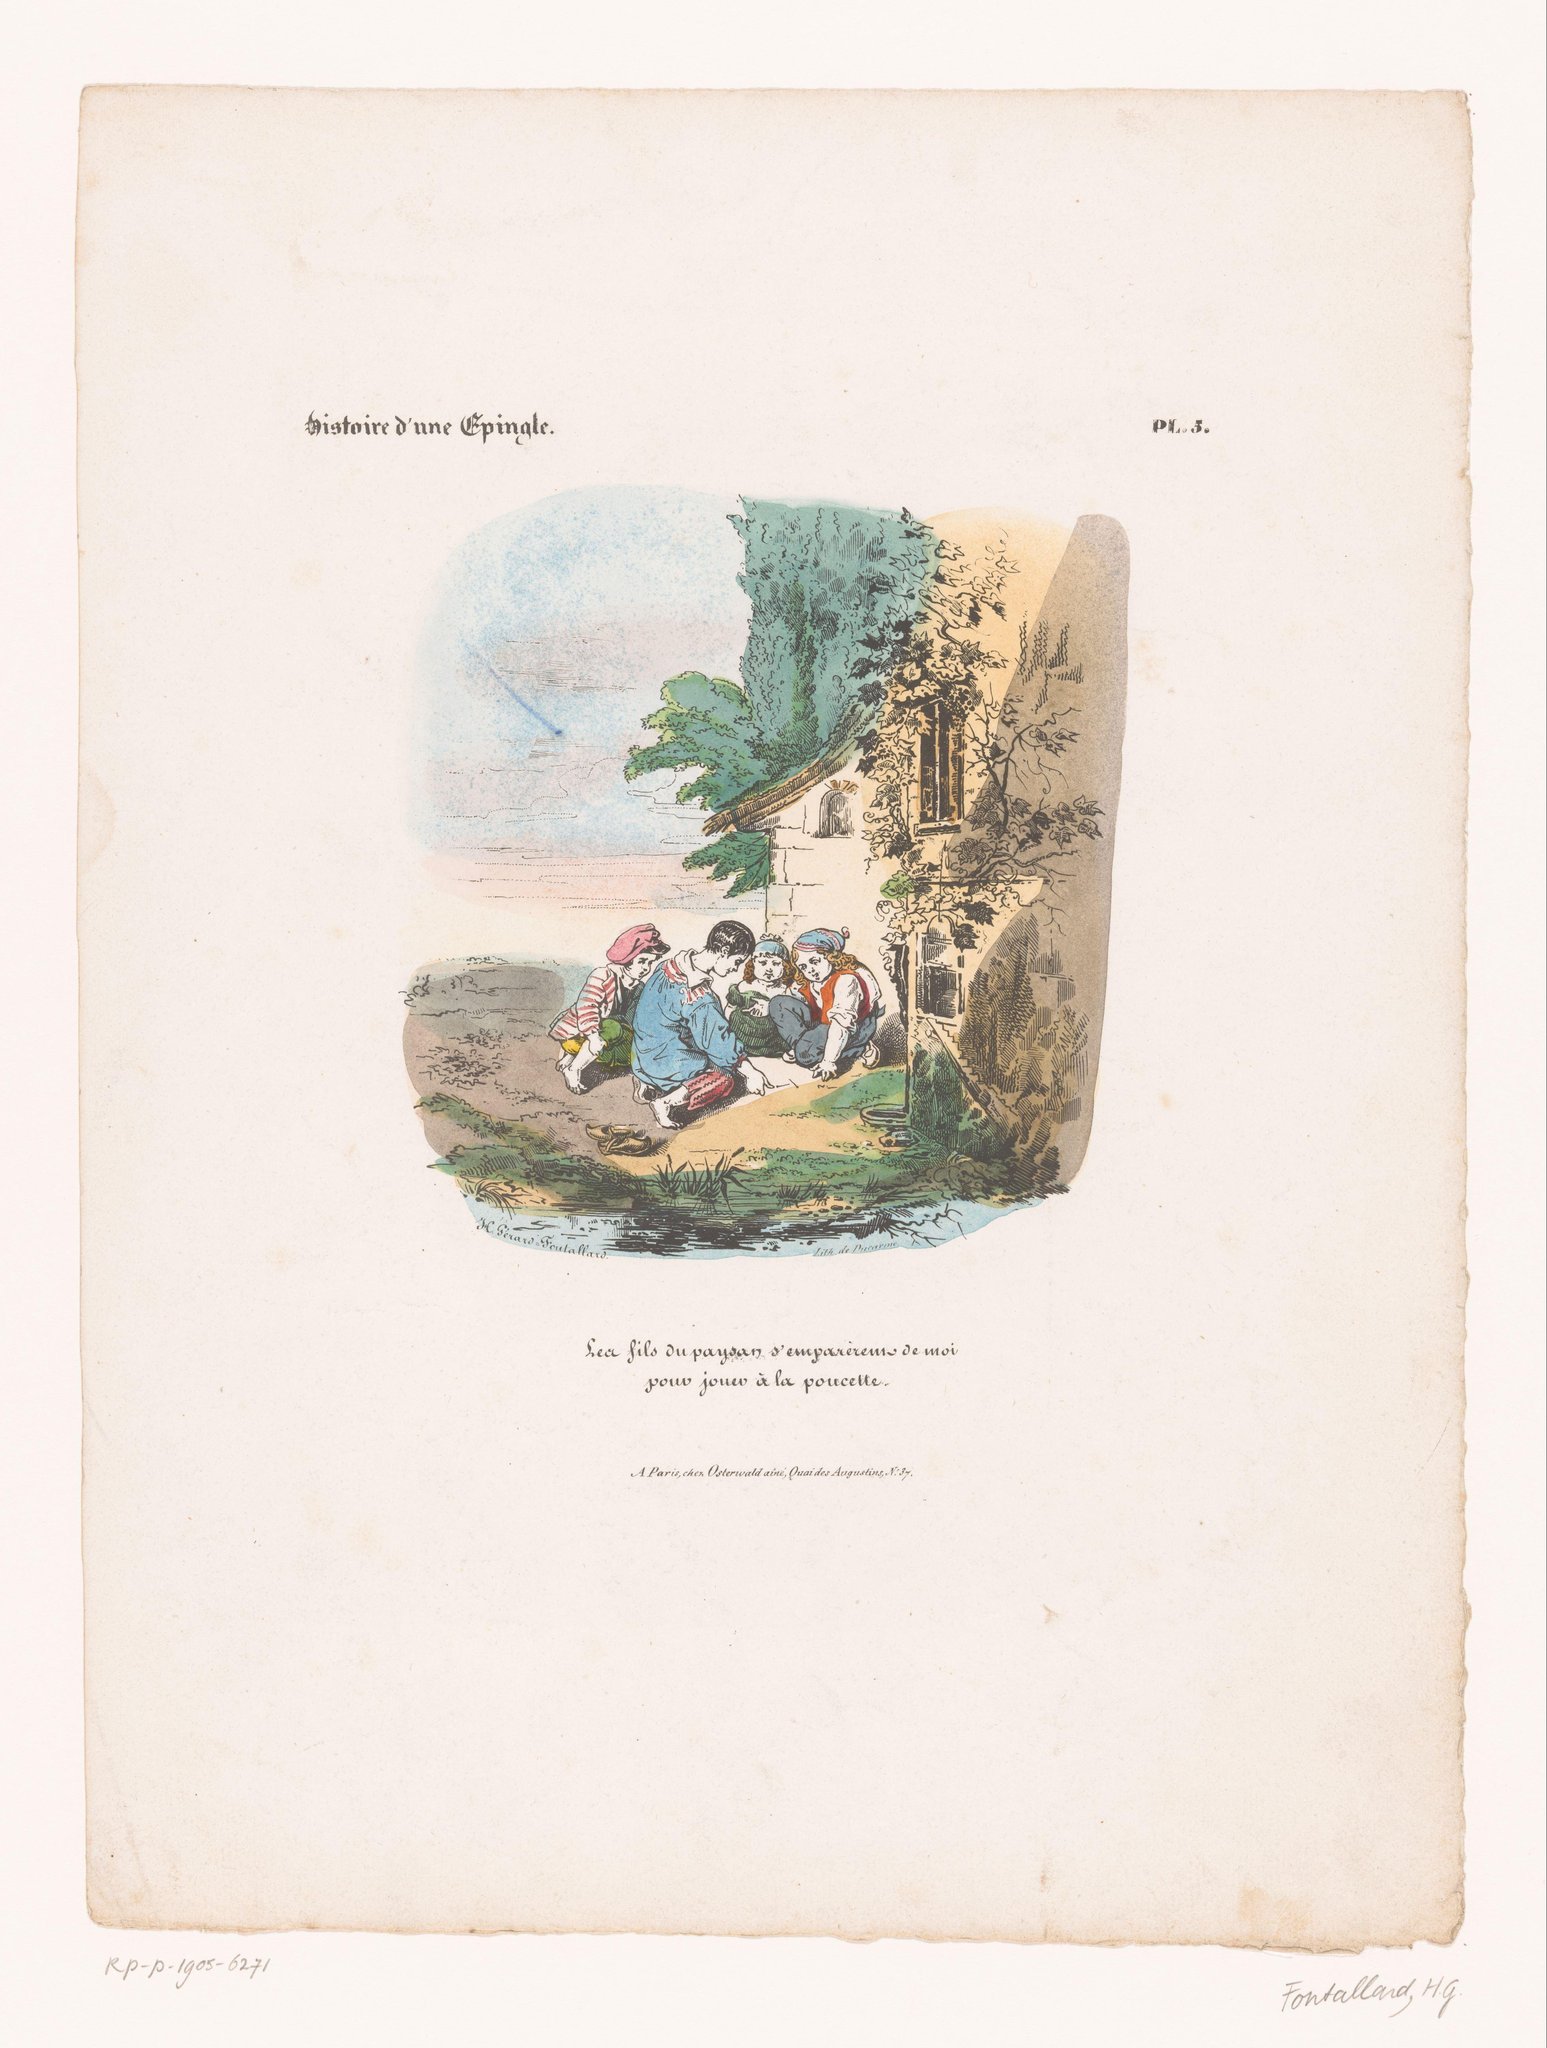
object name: print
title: Vier boerenjongens spelen met spelden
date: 1828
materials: paper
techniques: hand coloring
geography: paris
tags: boy (child between toddler and youth), games using special objects (marbles, top, hoop, etc.), pin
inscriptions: collector's mark: Lugt 2228a